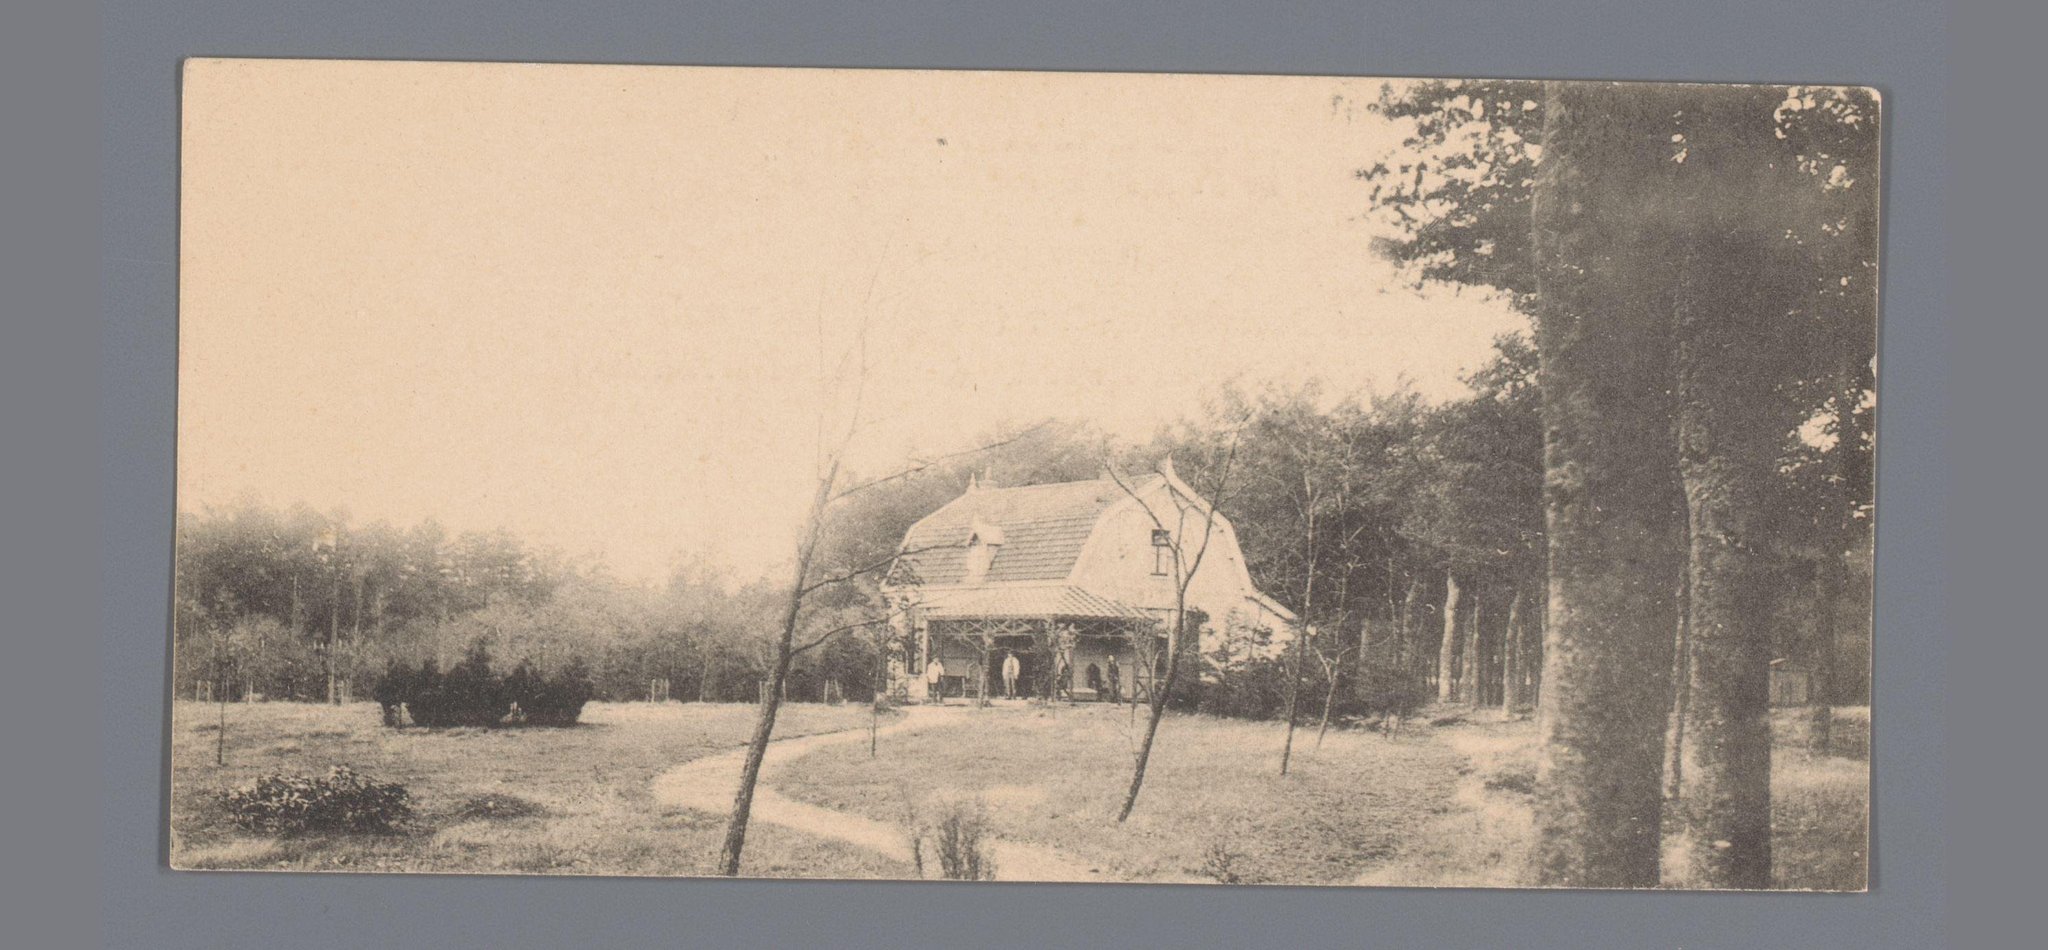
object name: photomechanical print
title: Gezicht op een landhuis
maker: Anonymous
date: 1880-1930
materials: paper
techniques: photograph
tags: rural housing, e.g. country-house, villa, cottage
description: Op verso staan regels om te versturen als briefkaart.